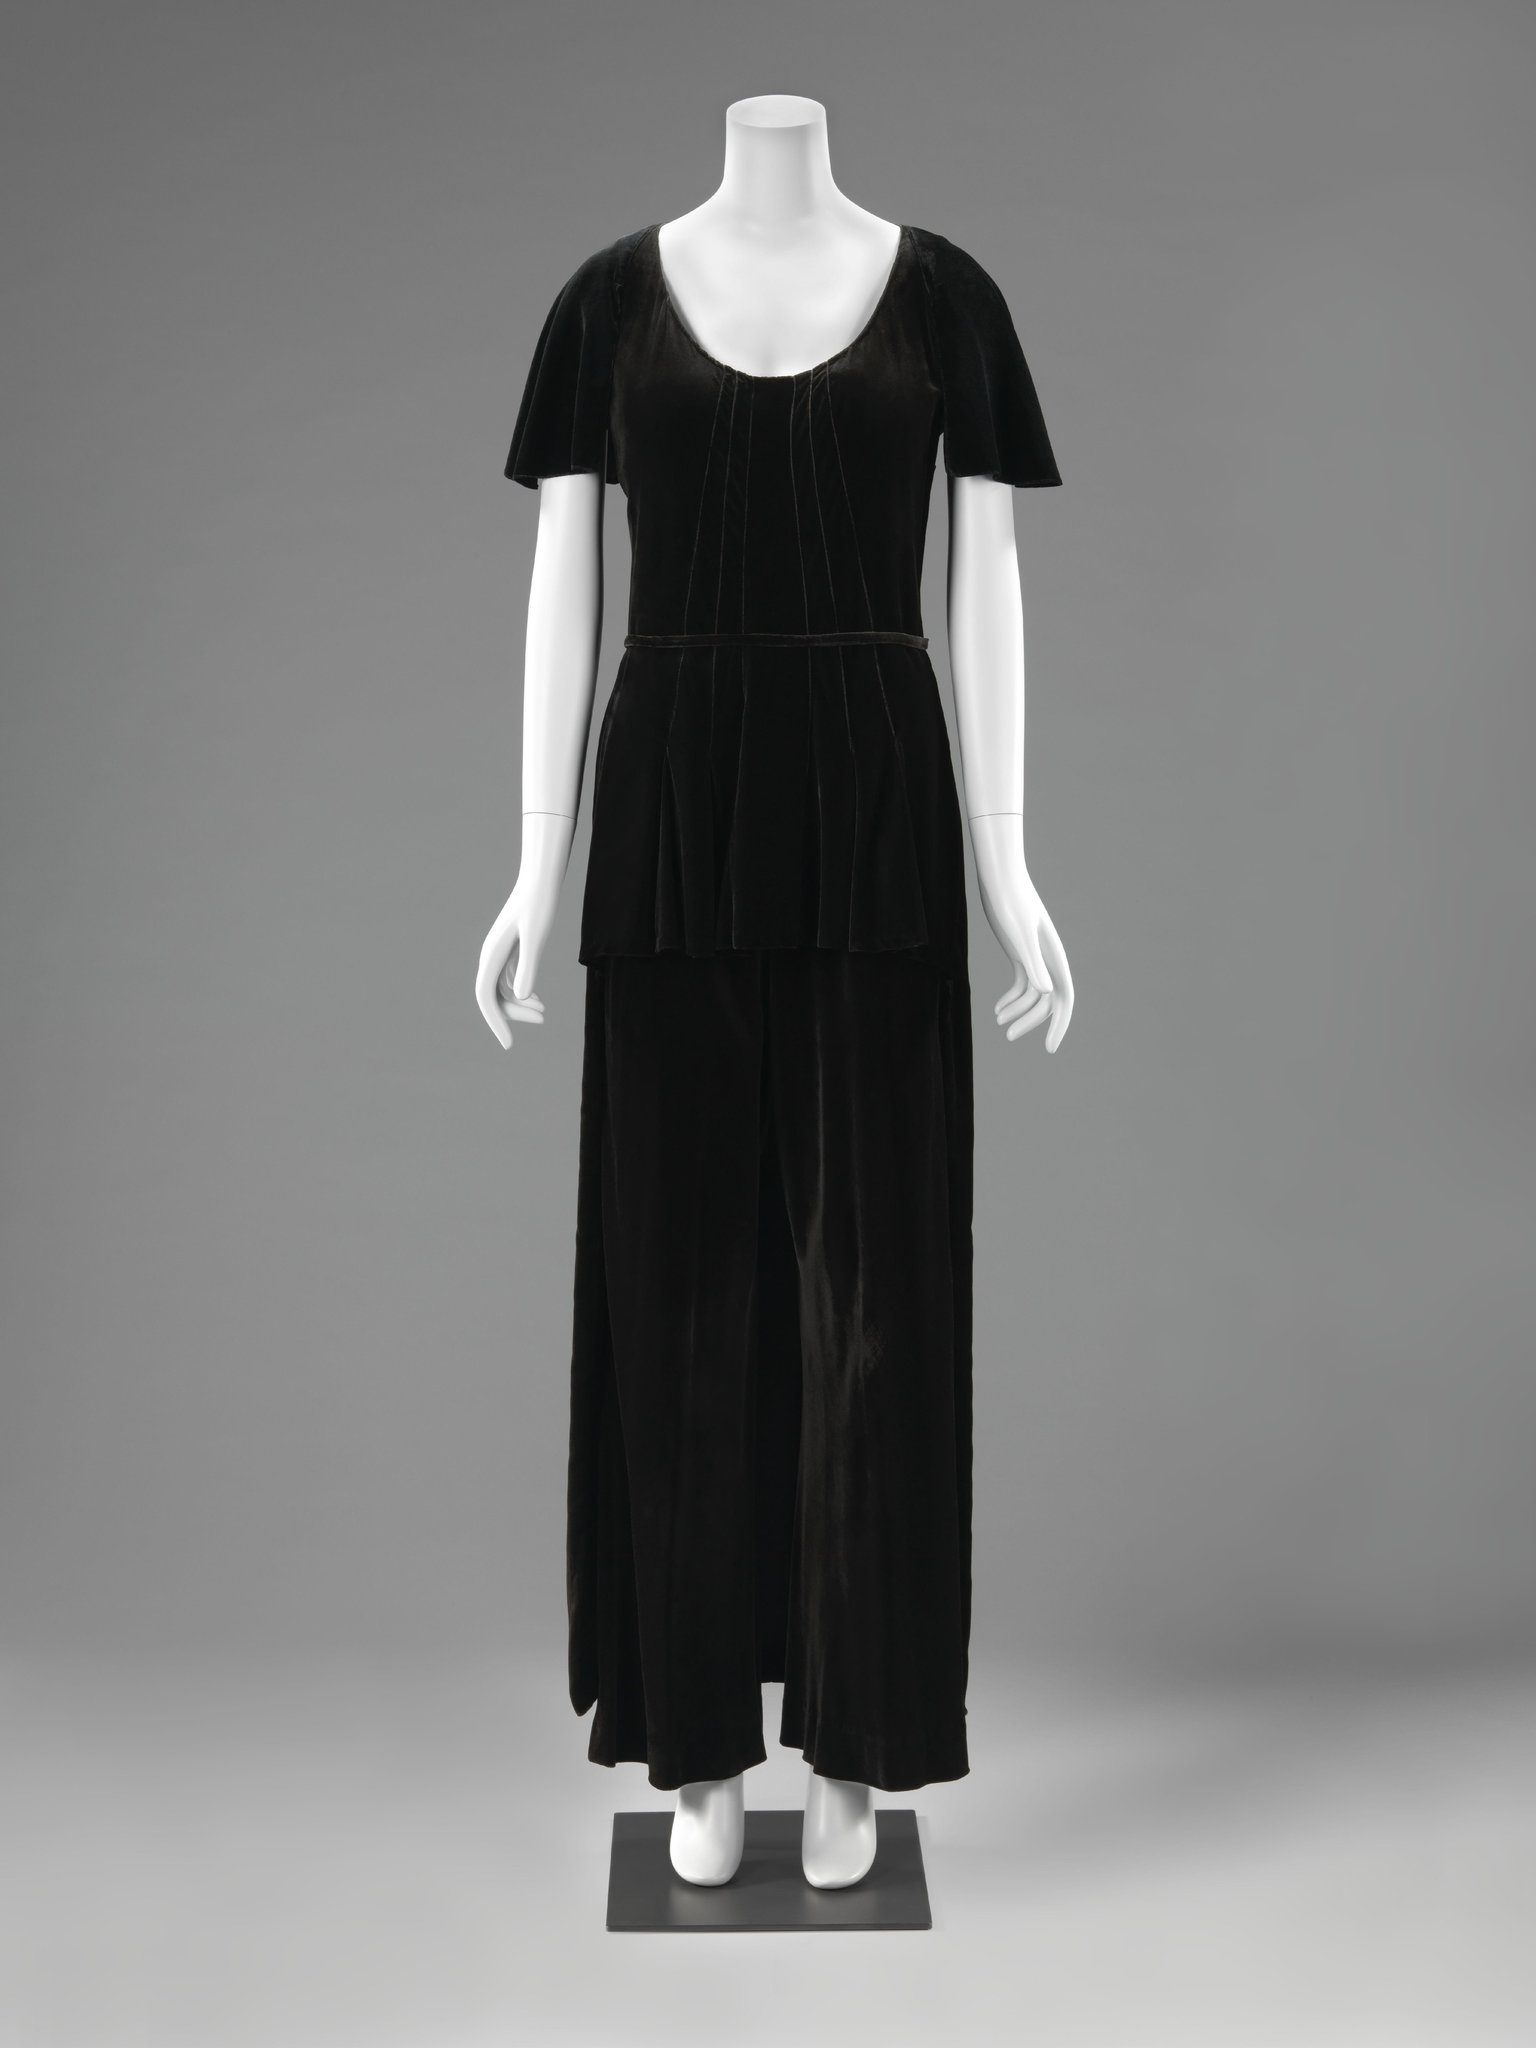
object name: complet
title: Lounging Pyjamas with Train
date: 1925-1930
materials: chine, silk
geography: brussels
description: In the 1920s fashionable young women wore pyjamas as loungewear. Around 1930 they also began to wear them when they went out to dine with friends. These pyjamas may have been the creation of the famous French fashion designer Gabriëlle Chanel. A label is sewn into the left trouser leg on which is written: ‘Pyjama Abdulah, Chanel.’